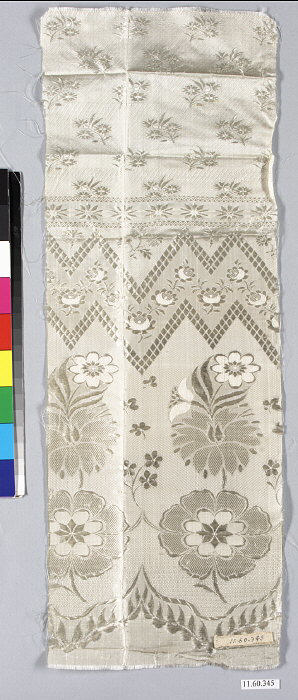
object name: fragment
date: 1801-1900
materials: silk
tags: flowers,leaves